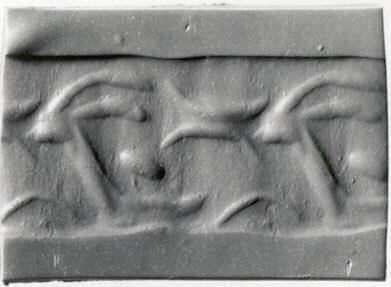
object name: cylinder seal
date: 2900-2700 BCE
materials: stone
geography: mesopotamia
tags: animals